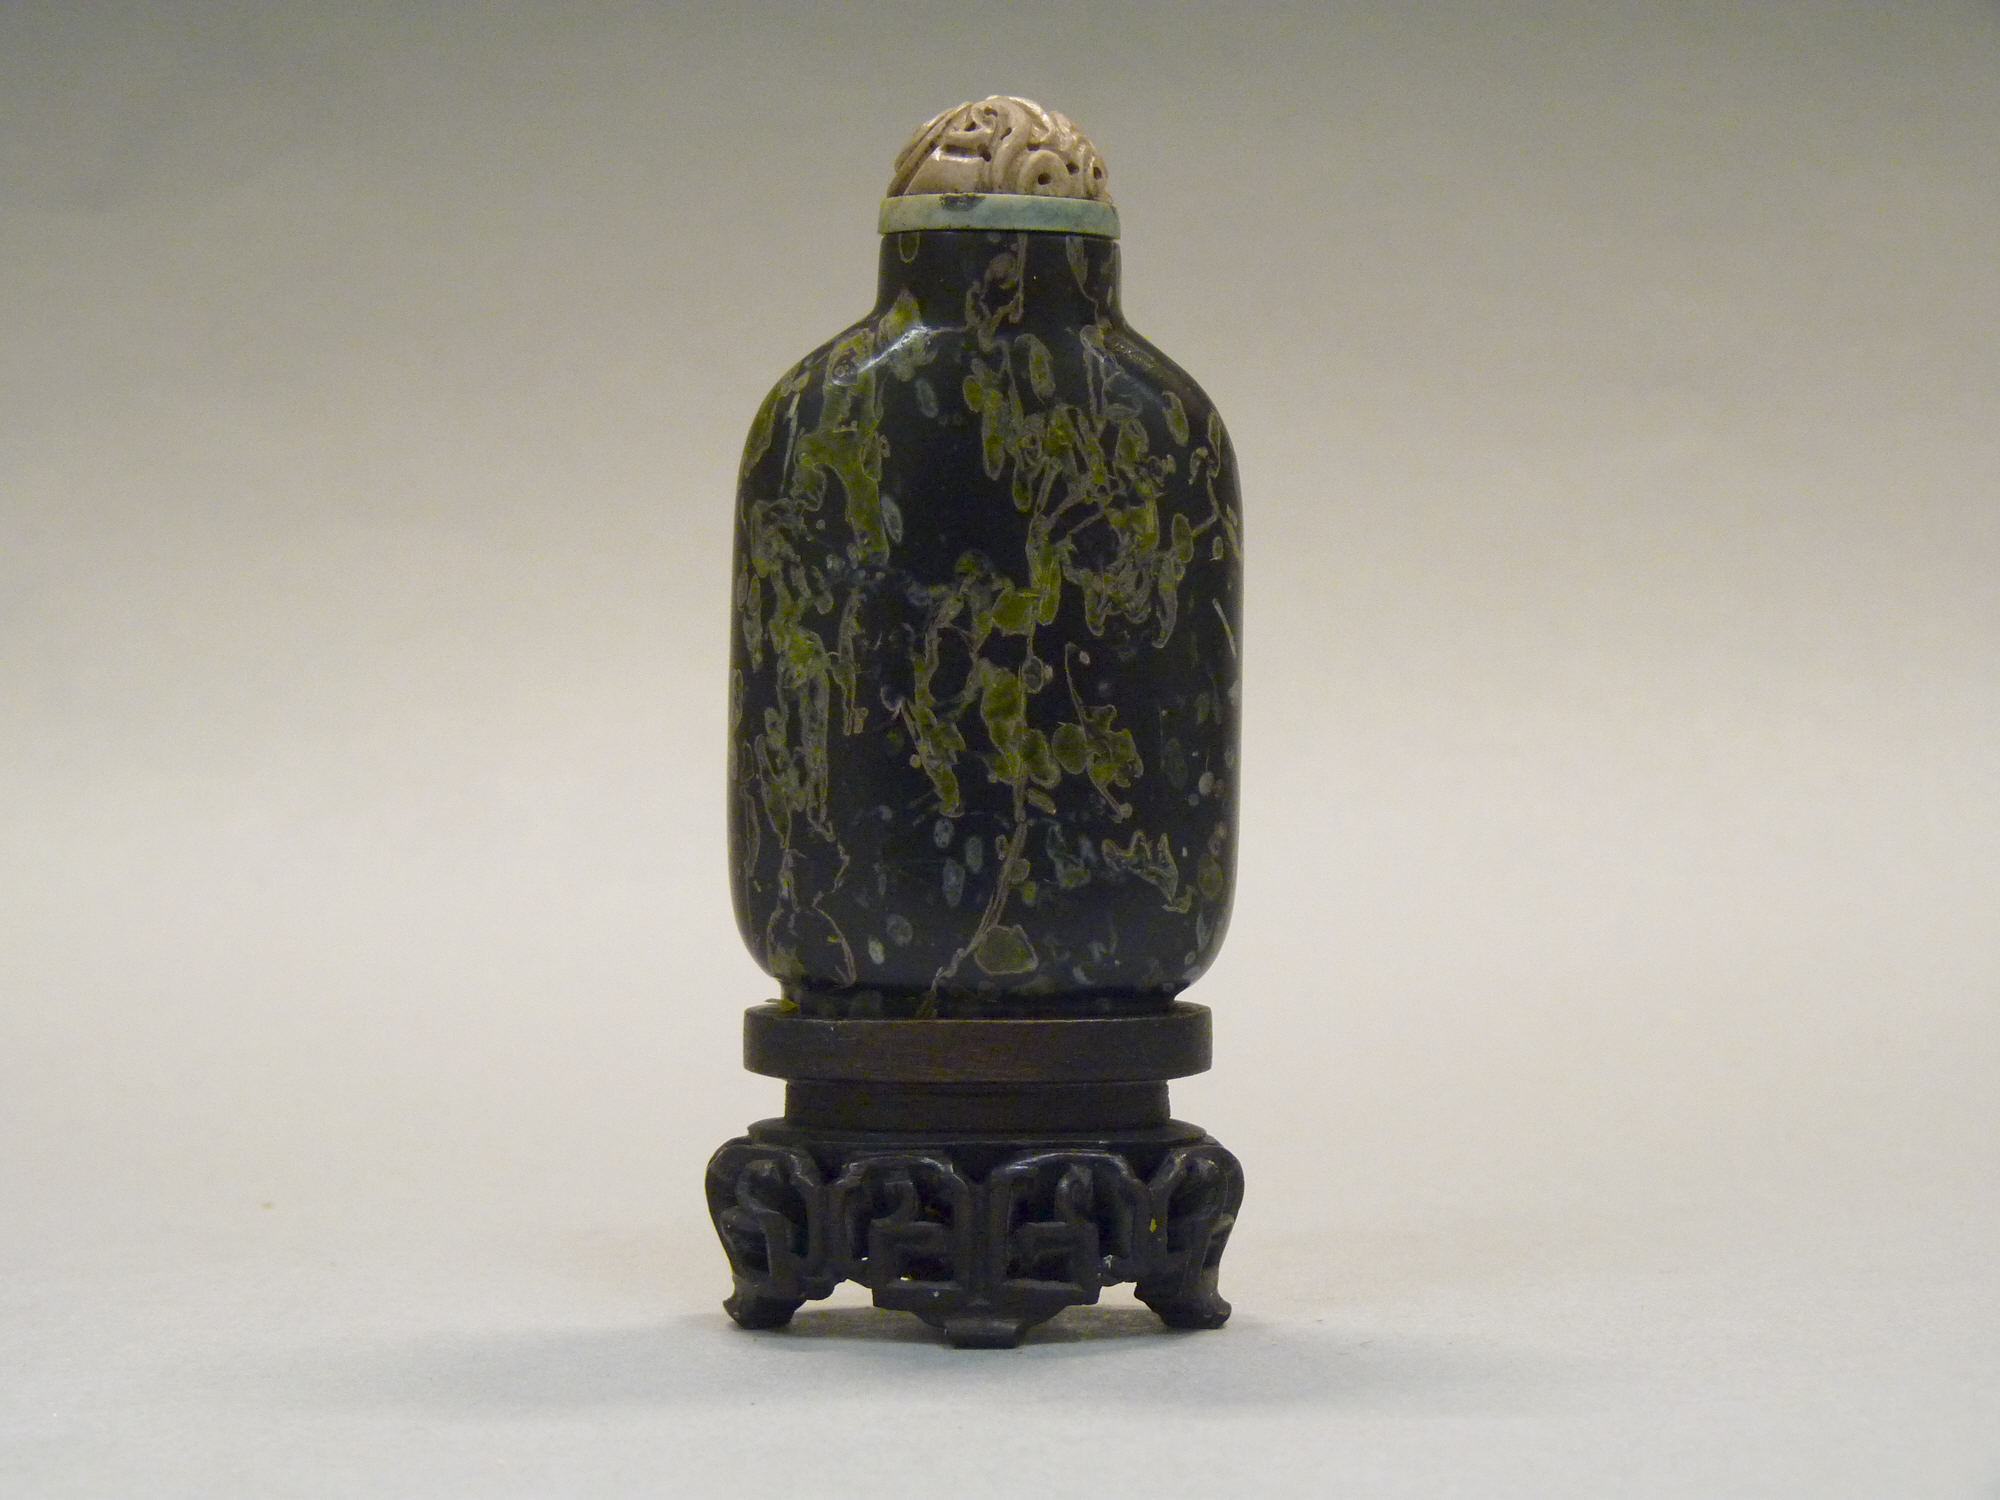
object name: snuff bottle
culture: chinese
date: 1736-1795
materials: coral, stone